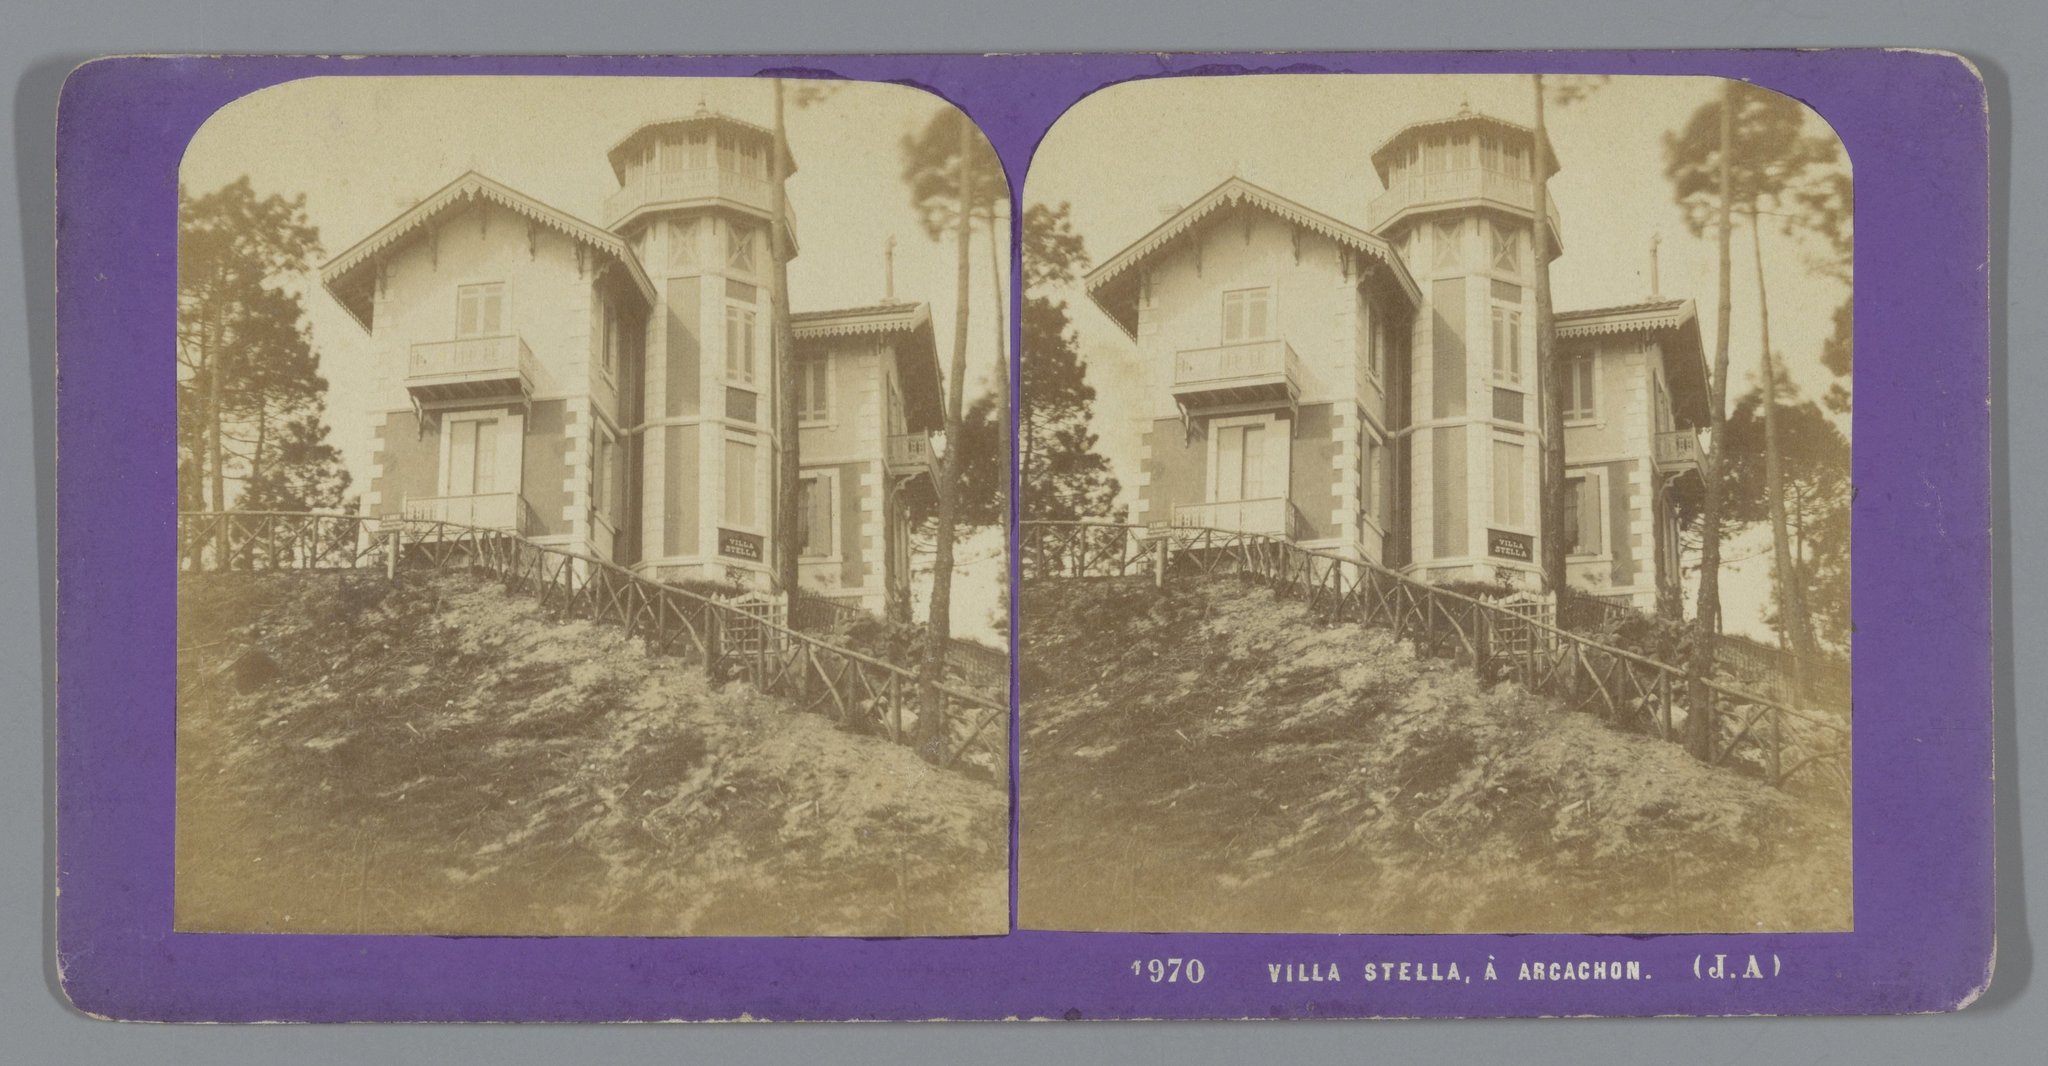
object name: stereograph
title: Villa Stella, à Arcachon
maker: jean andrieu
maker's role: fotograaf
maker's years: 1816-1872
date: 1862-1876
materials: cardboard, photographic support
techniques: albumen print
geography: arcachon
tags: rural housing, e.g. country-house, villa, cottage, façade (of house or building)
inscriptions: number: ‘1970’